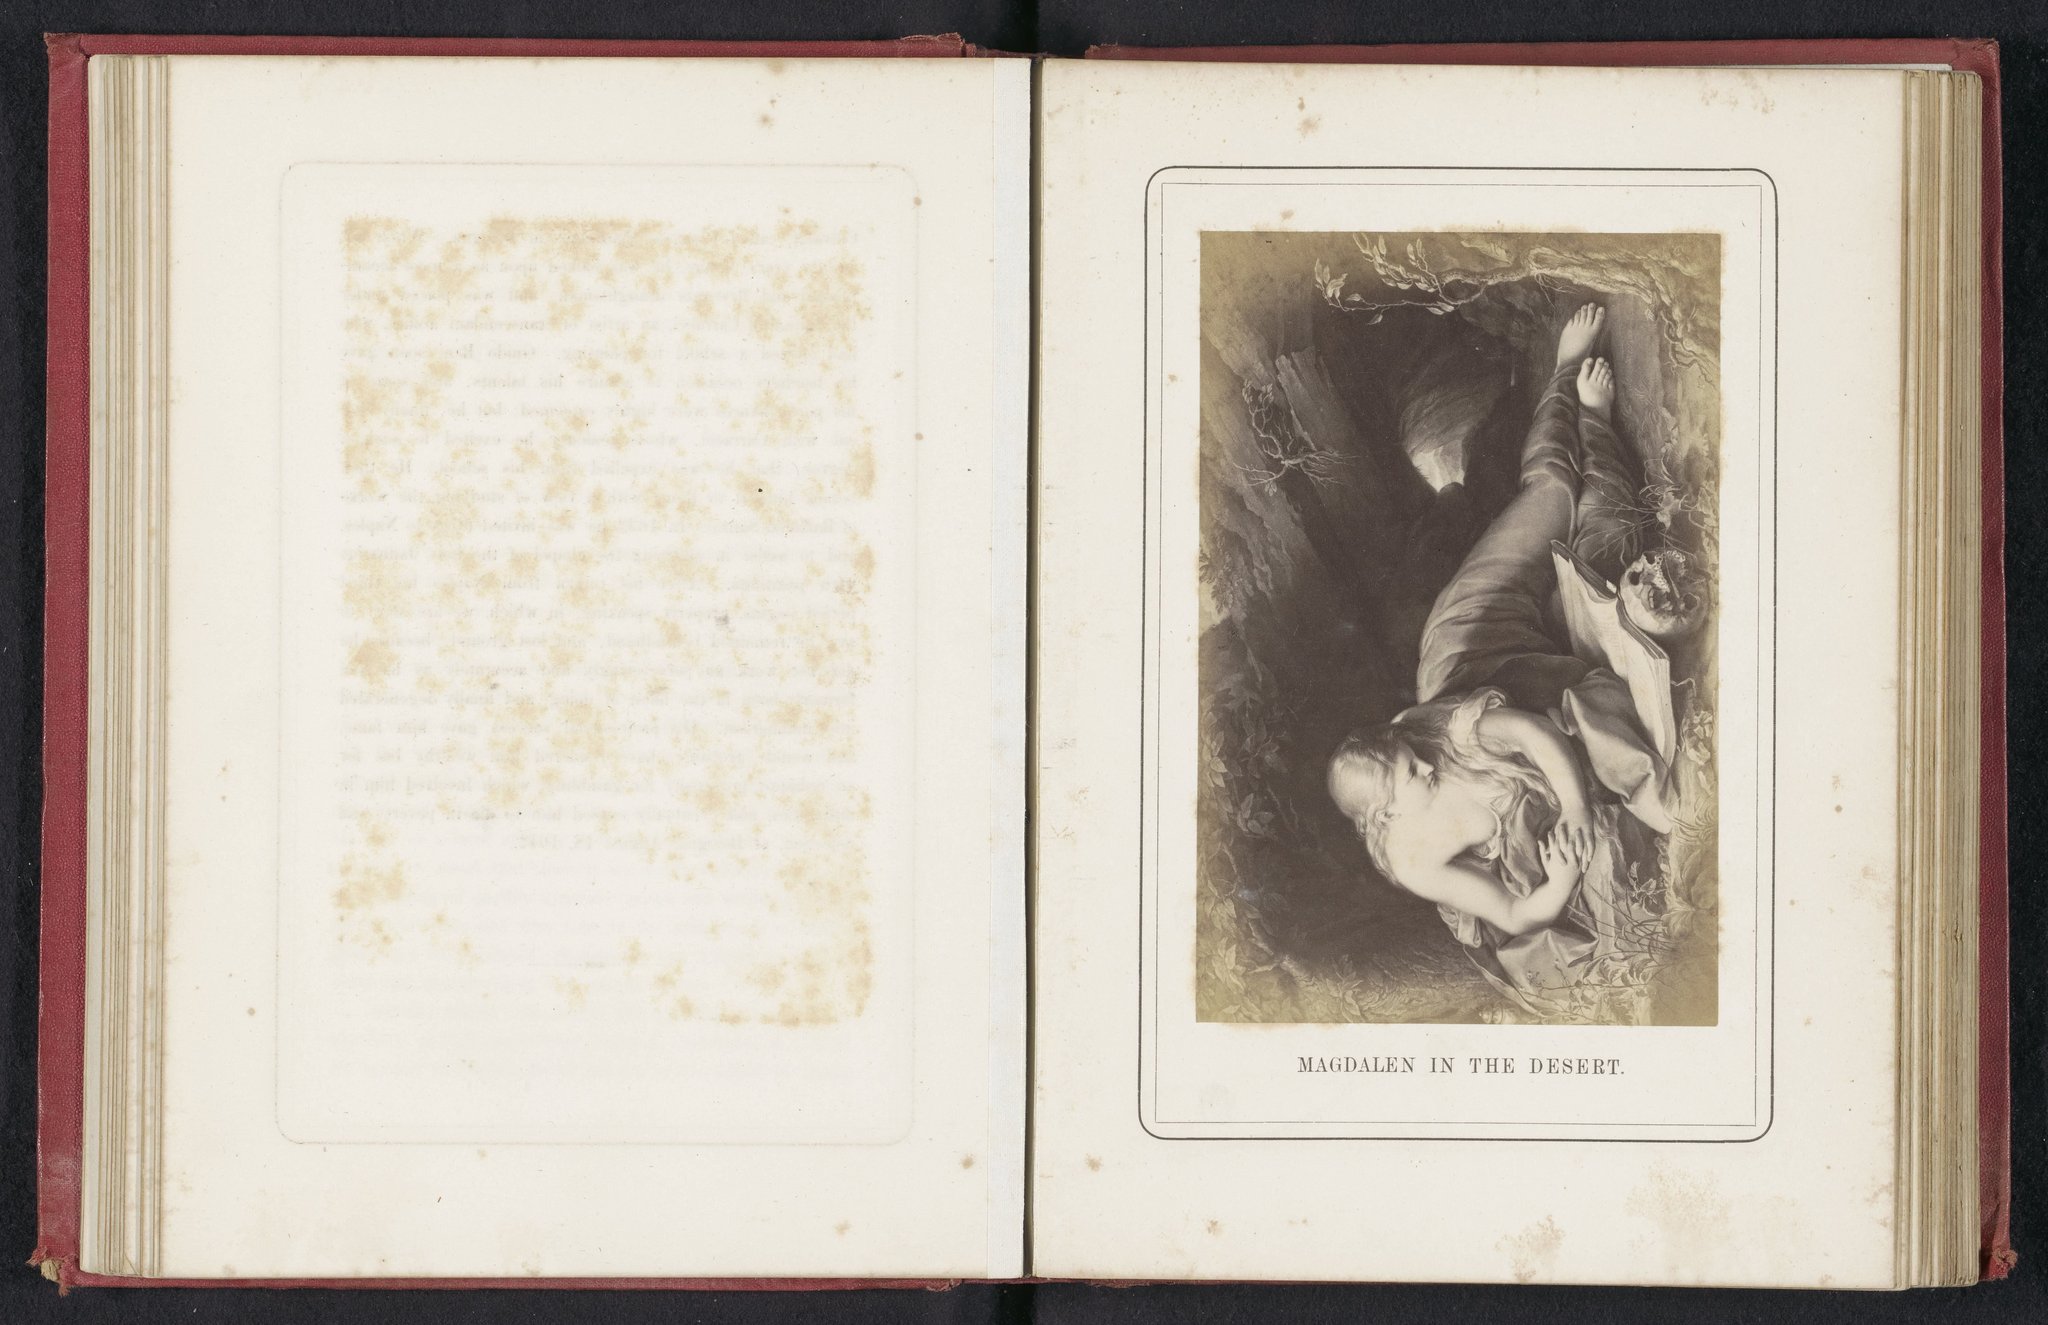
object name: page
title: Magdalen in the desert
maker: hanns hanfstaengl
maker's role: print maker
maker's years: 1820-1885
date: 1854-1864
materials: photographic support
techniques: albumen print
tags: picture, painting, the penitent harlot mary magdalene; possible attributes: book (or scroll), crown, crown of thorns, crucifix, jar of ointment, mirror, musical instrument, palm-branch, rosary, scourge